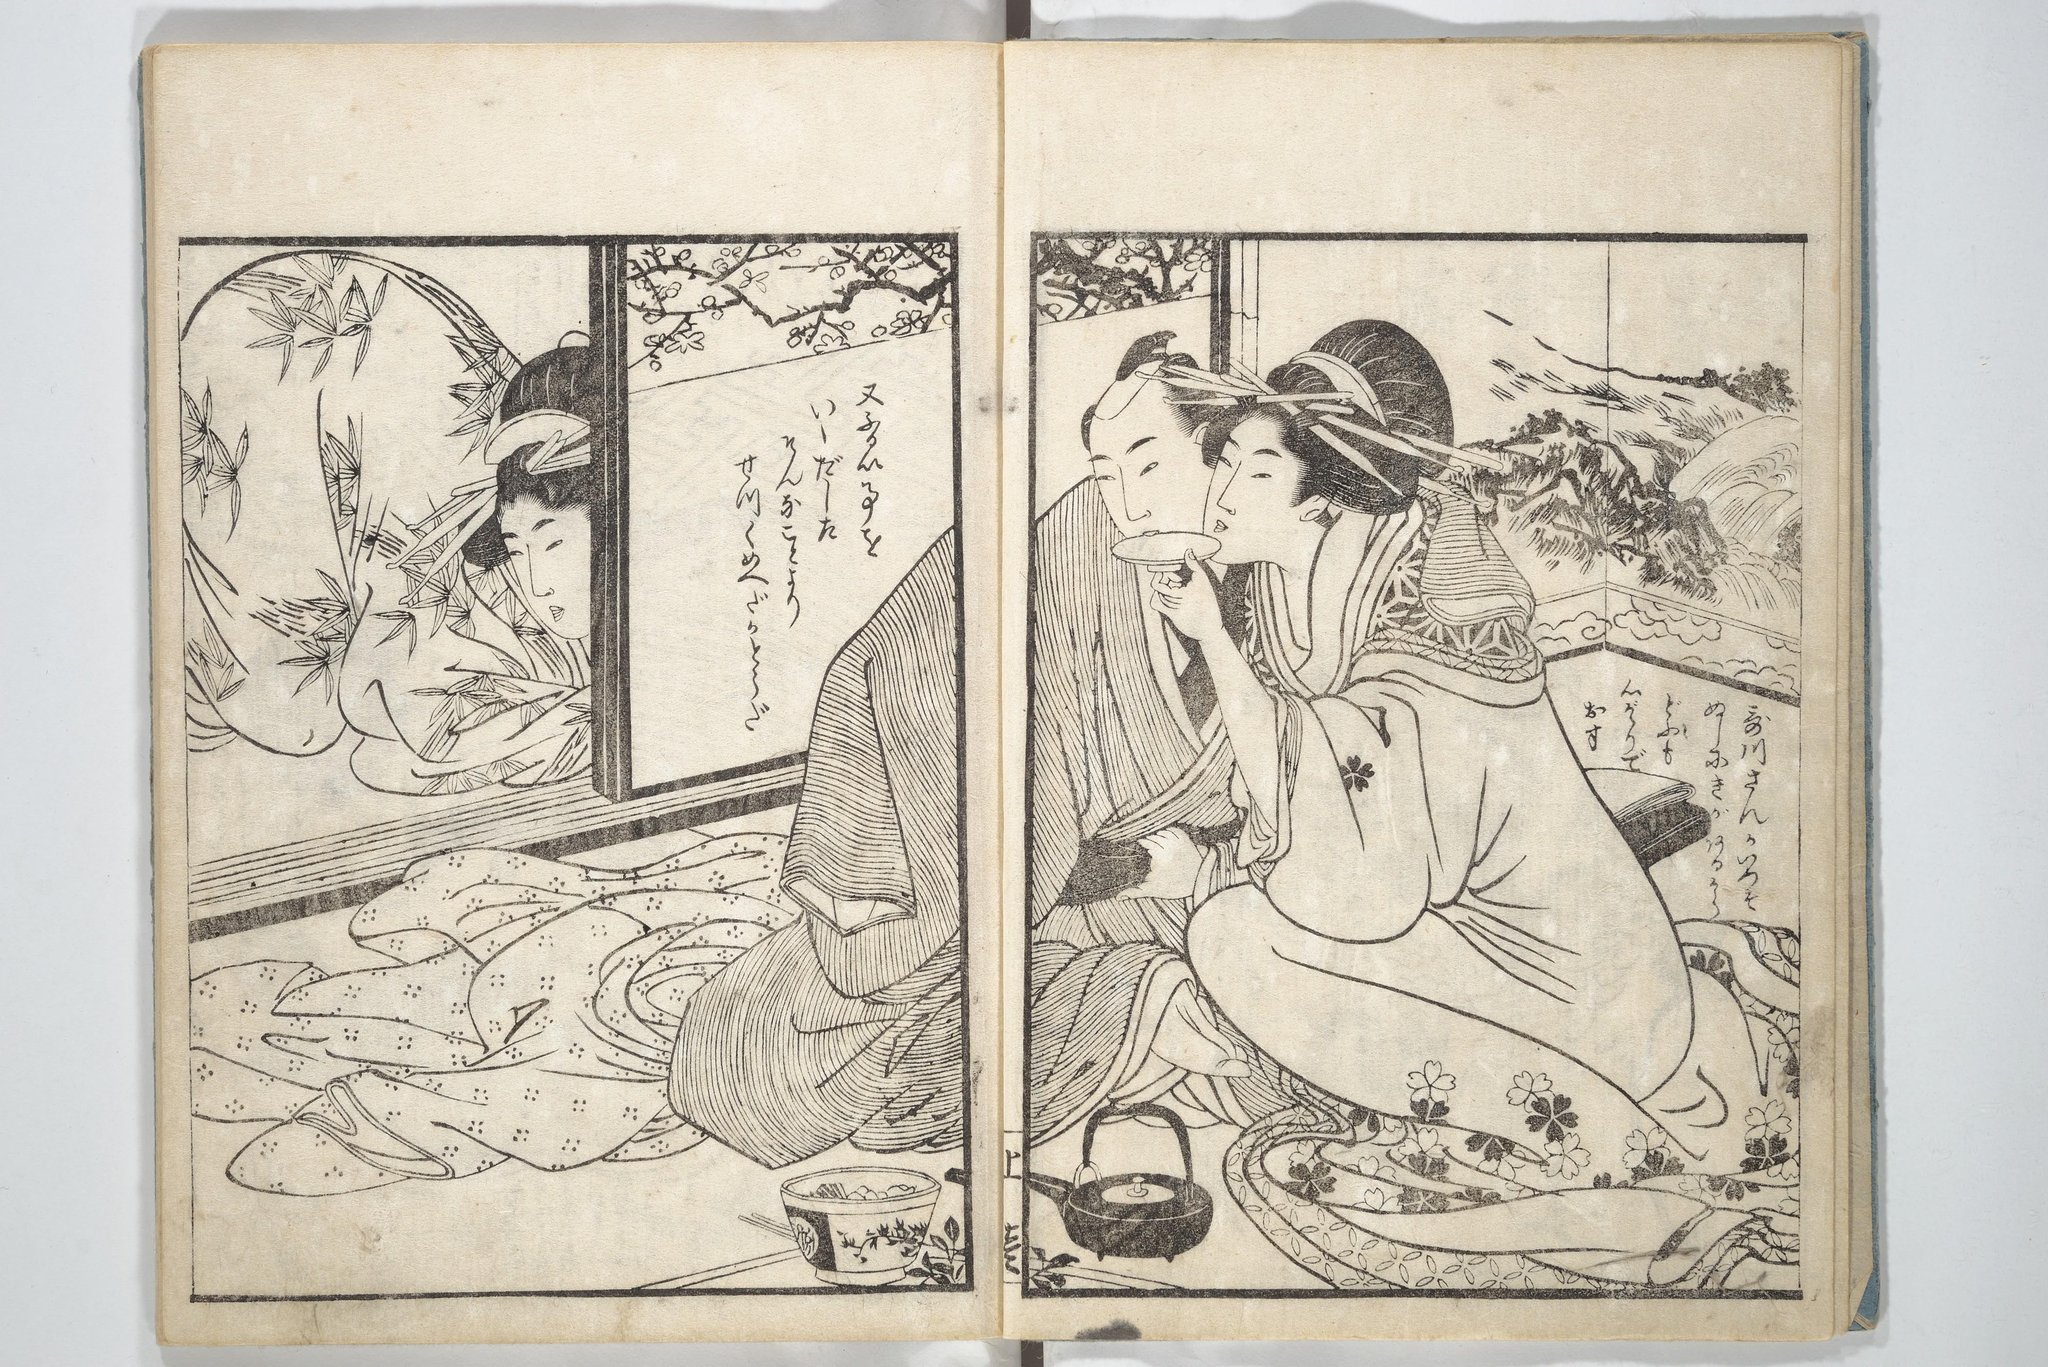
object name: illustrated book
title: Picture Book of the Hitachi Obi (Enpon futahashira) 艶本婦多柱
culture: japanese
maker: kitagawa utamaro 喜多川歌麿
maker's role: artist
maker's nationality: japanese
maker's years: 1754-1806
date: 1803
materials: ink, paper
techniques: woodblock print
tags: men,women